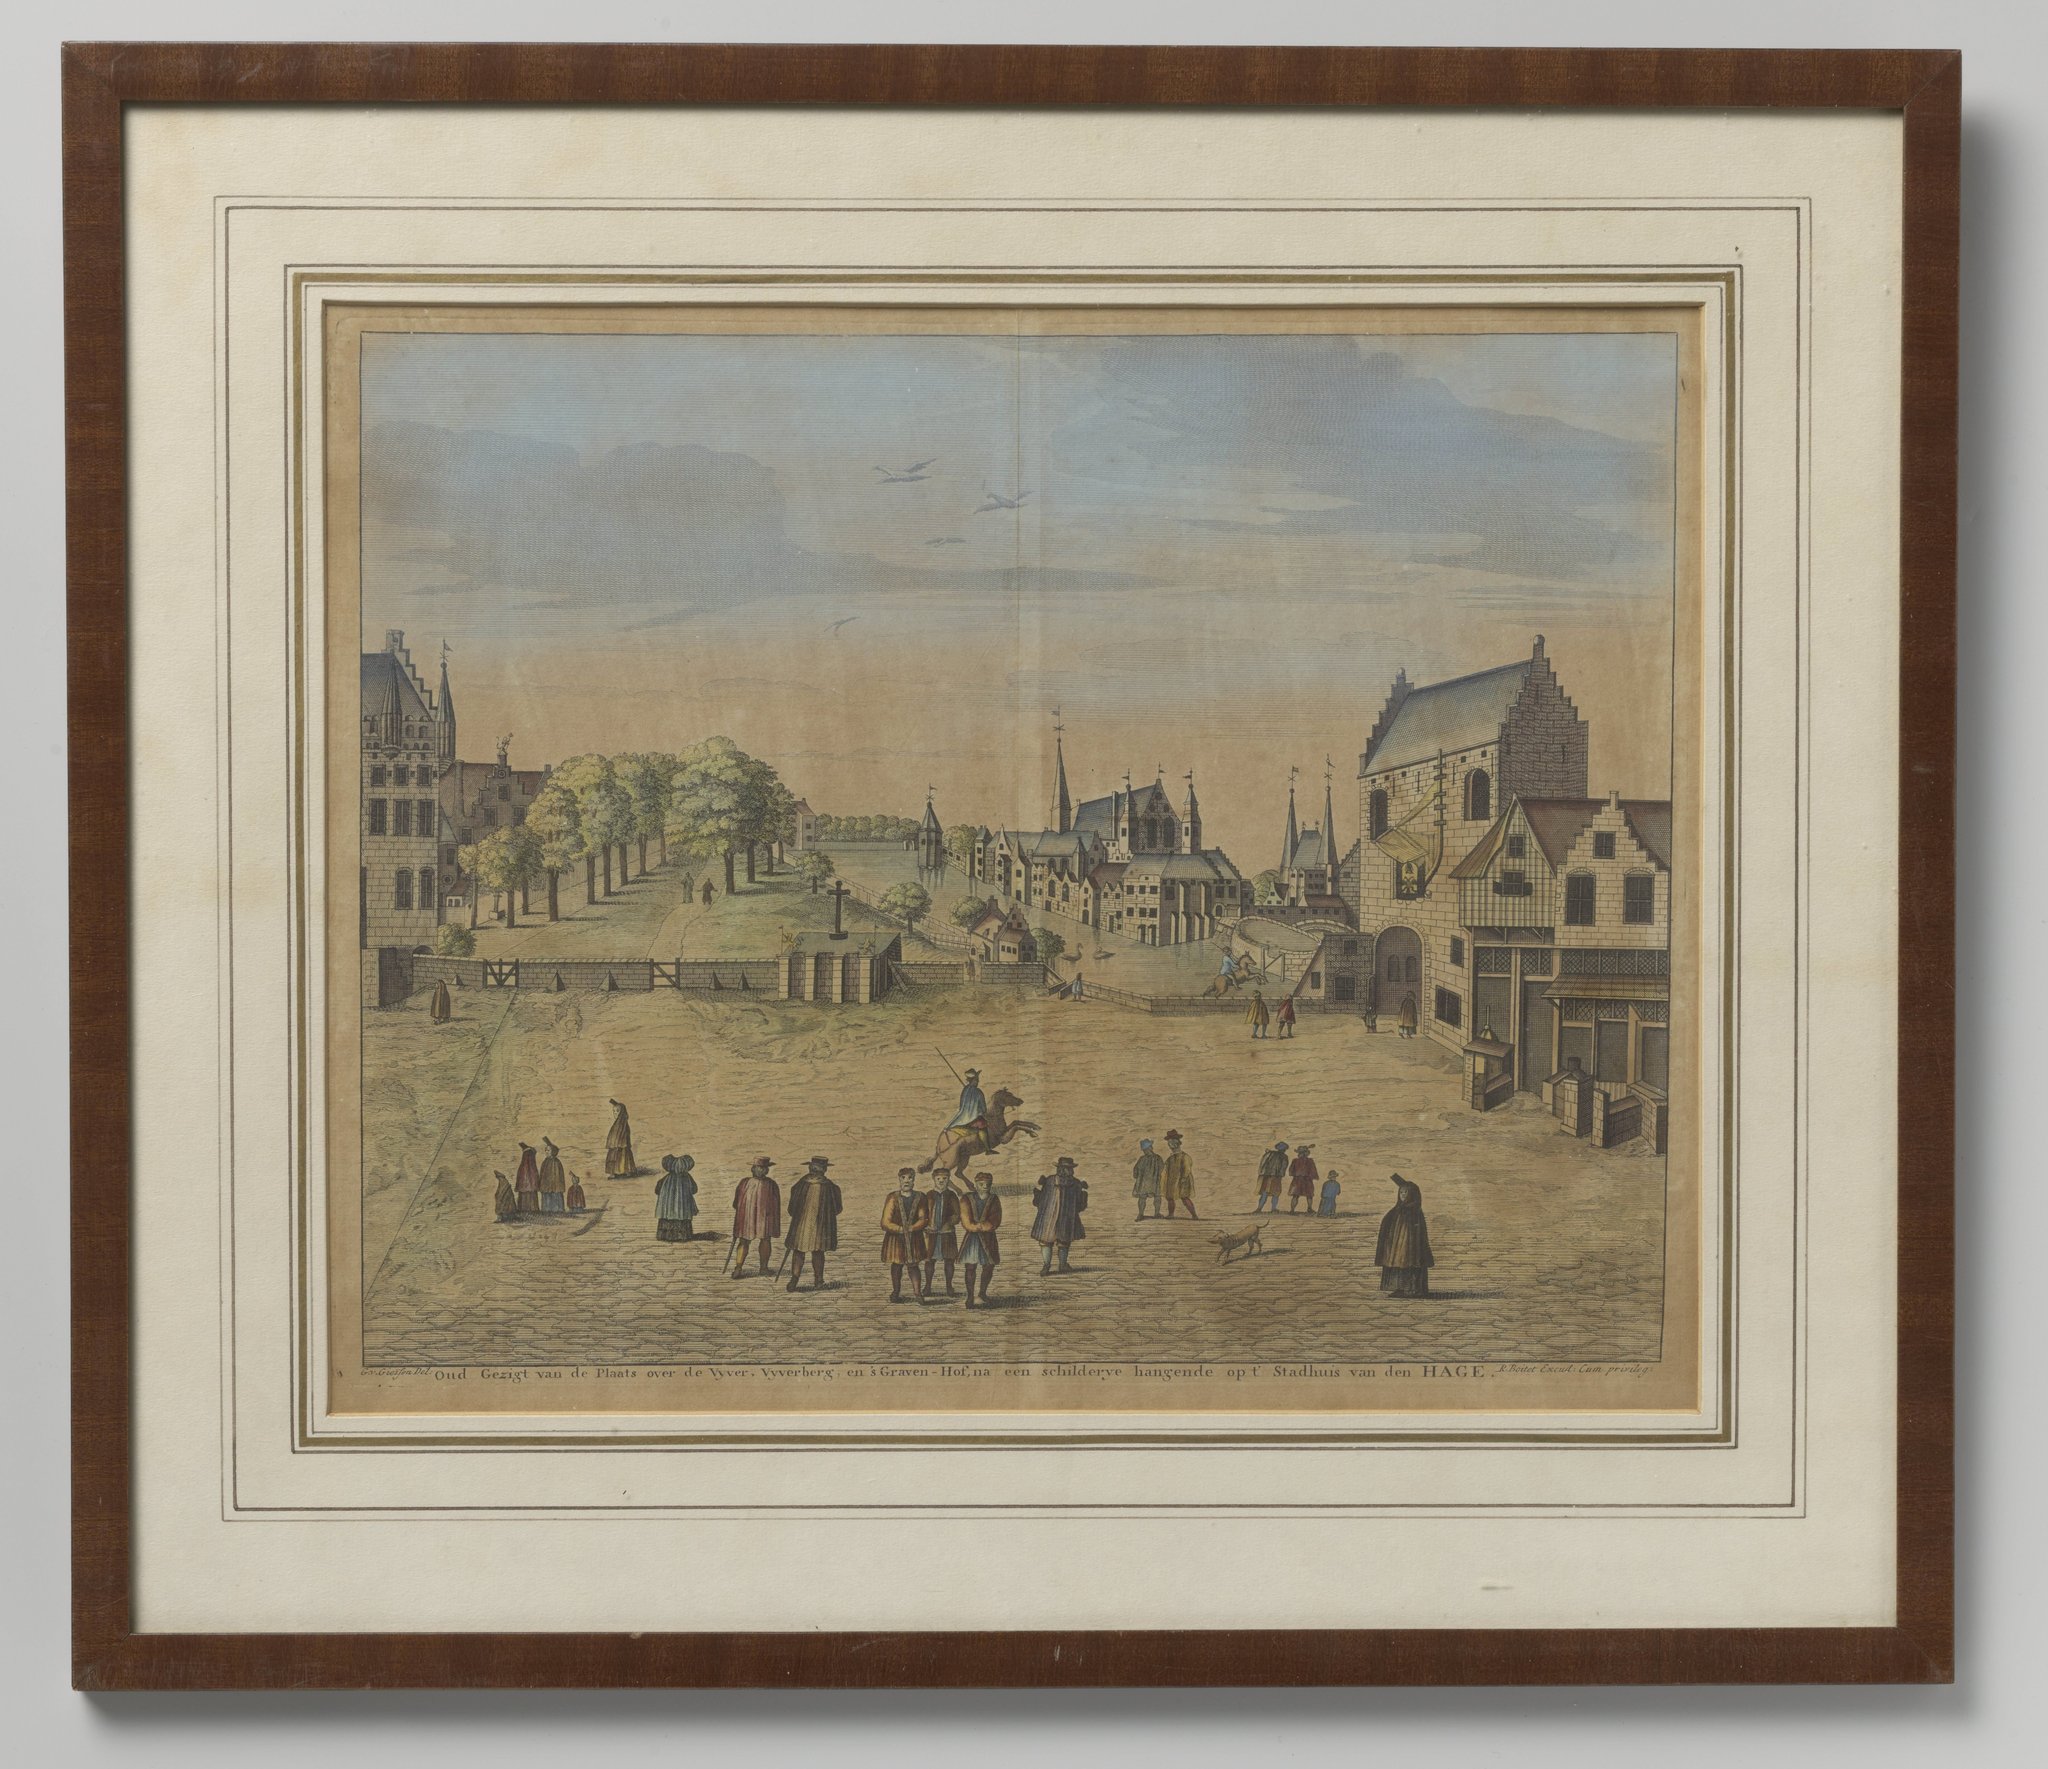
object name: print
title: Oud Gezigt van de Plaats over de Vijver, Vijverberg en 's-Gravenhof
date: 1714-1758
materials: paper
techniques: printing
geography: netherlands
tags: amsterdam, the hague, willem drees, public road (+ city(-scape) with figures, staffage)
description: Gekleurde prent op bruin verkleurd papier van plein met mensen voor gebouwen, een plantsoen, vijver en weer gebouwen met wimpels. Opgezet in papier, ingelijst in hout achter glas. Achterkant: 'Aangeboden op 24 juni 1955 aan Dr. W. Drees, Minister-President door de ambtenaren van het departement van algemene zaken ter gelegenheid van zijn tweede lustrum als minister.'